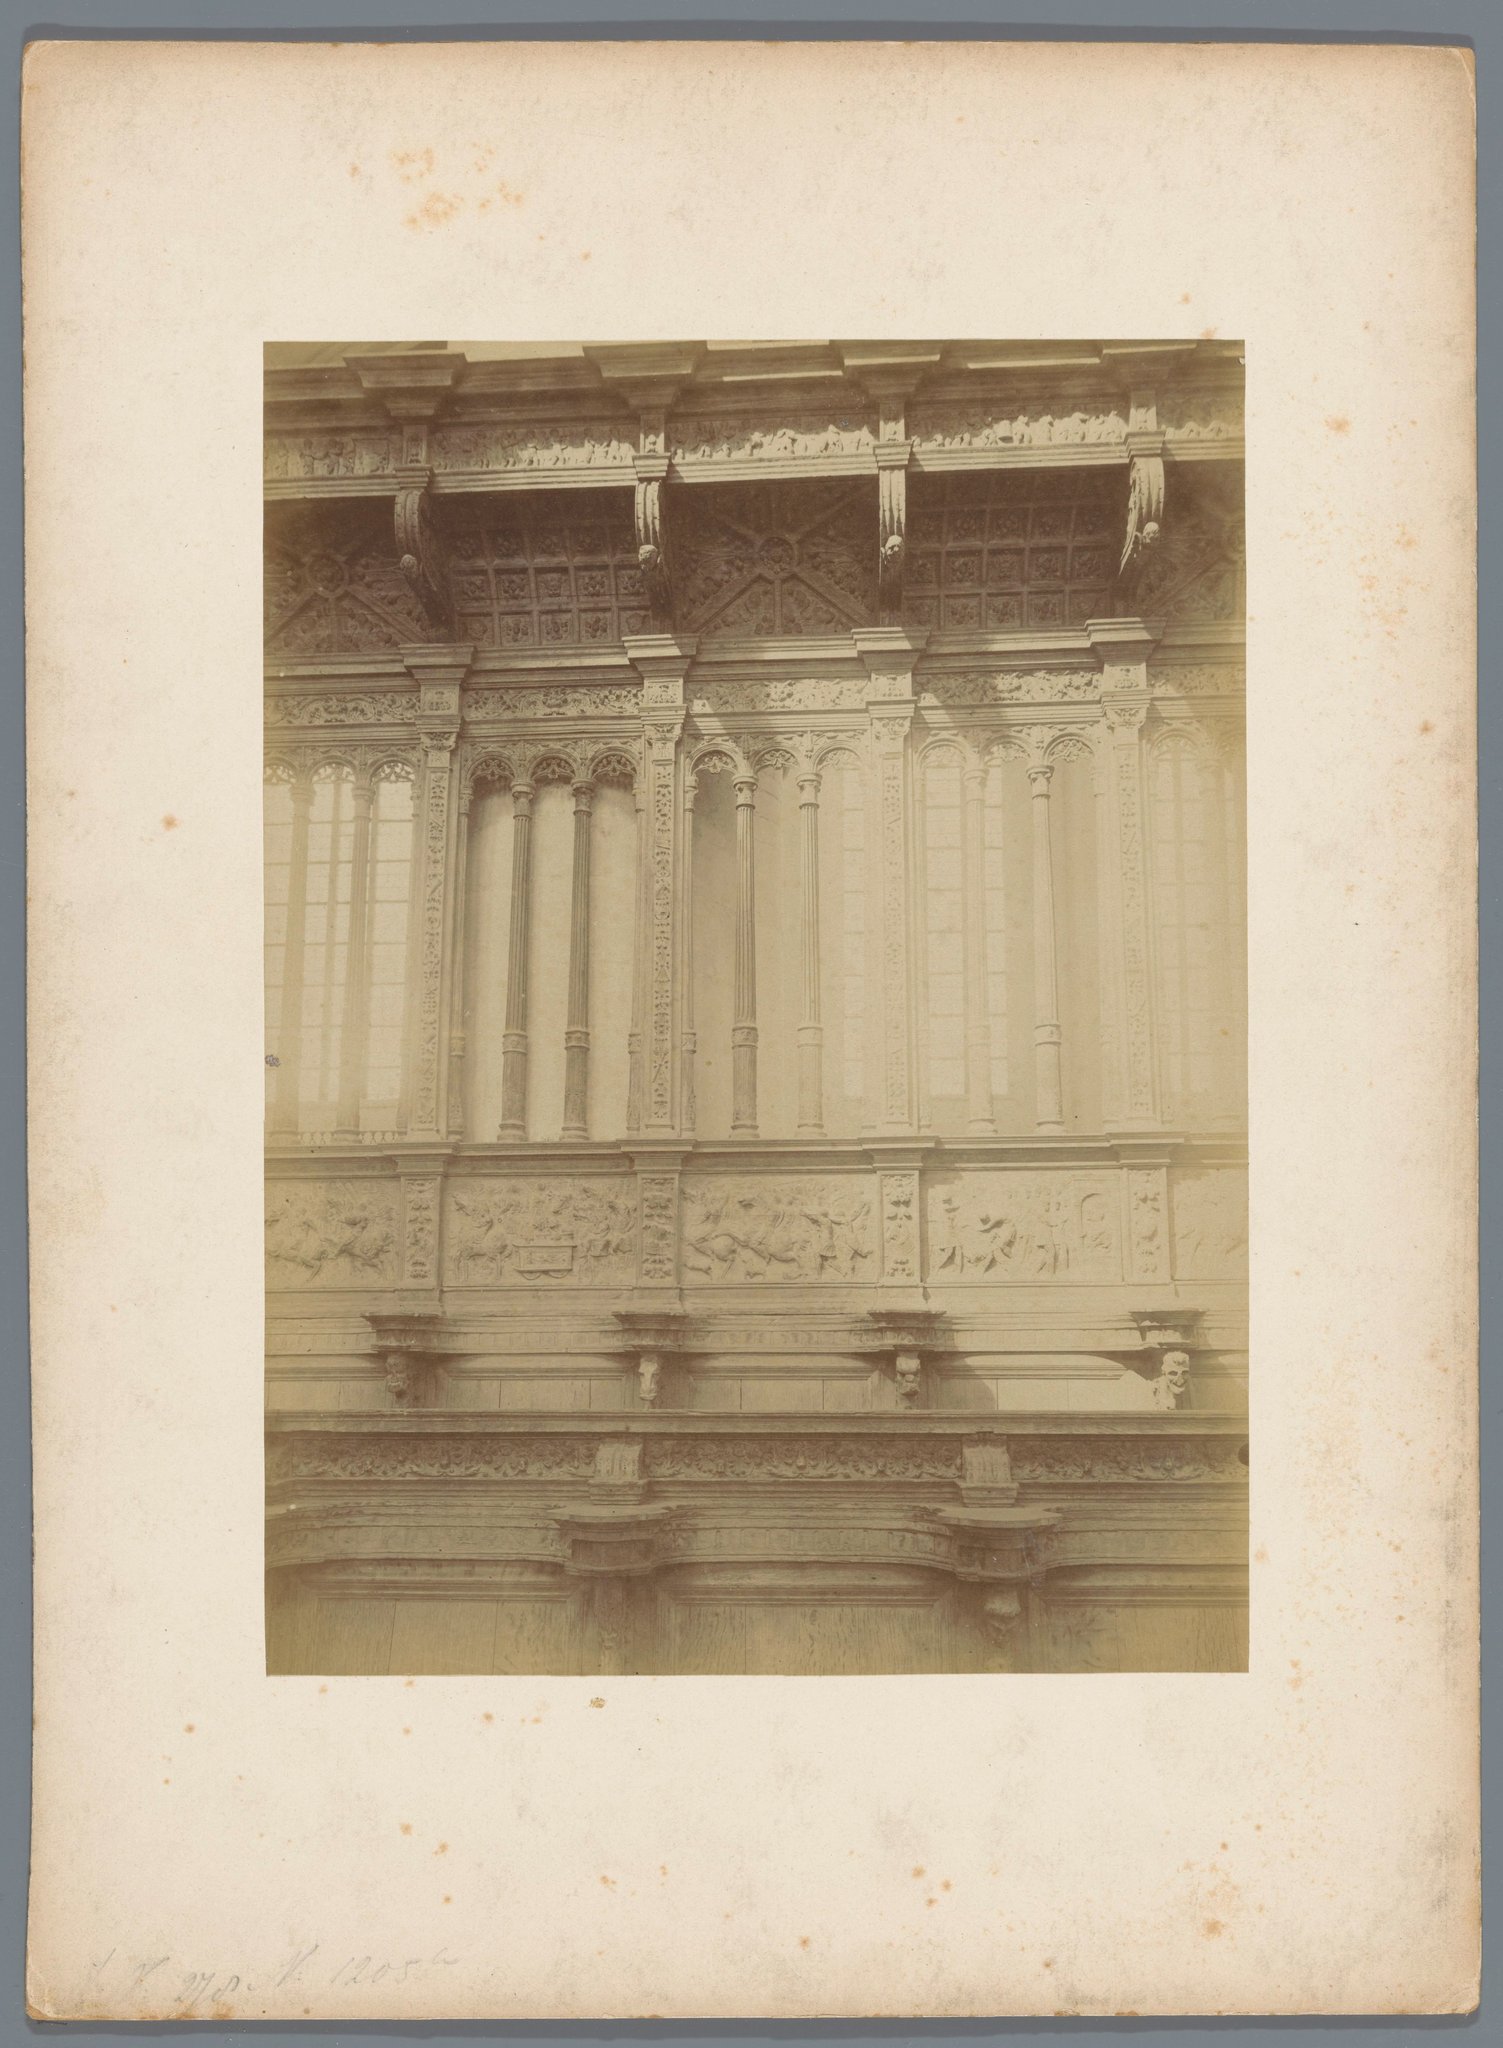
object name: photograph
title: Deel van de koorbanken in de Grote Kerk te Dordrecht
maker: Anonymous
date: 1875-1900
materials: cardboard, photographic support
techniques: albumen print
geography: grote of onze-lieve-vrouwekerk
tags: interior of church, seats of the clergy, choir-stalls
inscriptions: inscription: ‘6687 neg. no. 14471’, inscription: ‘Dordrecht. Z-H. Ned. Herv. Kerk Choorbanken.’, annotation